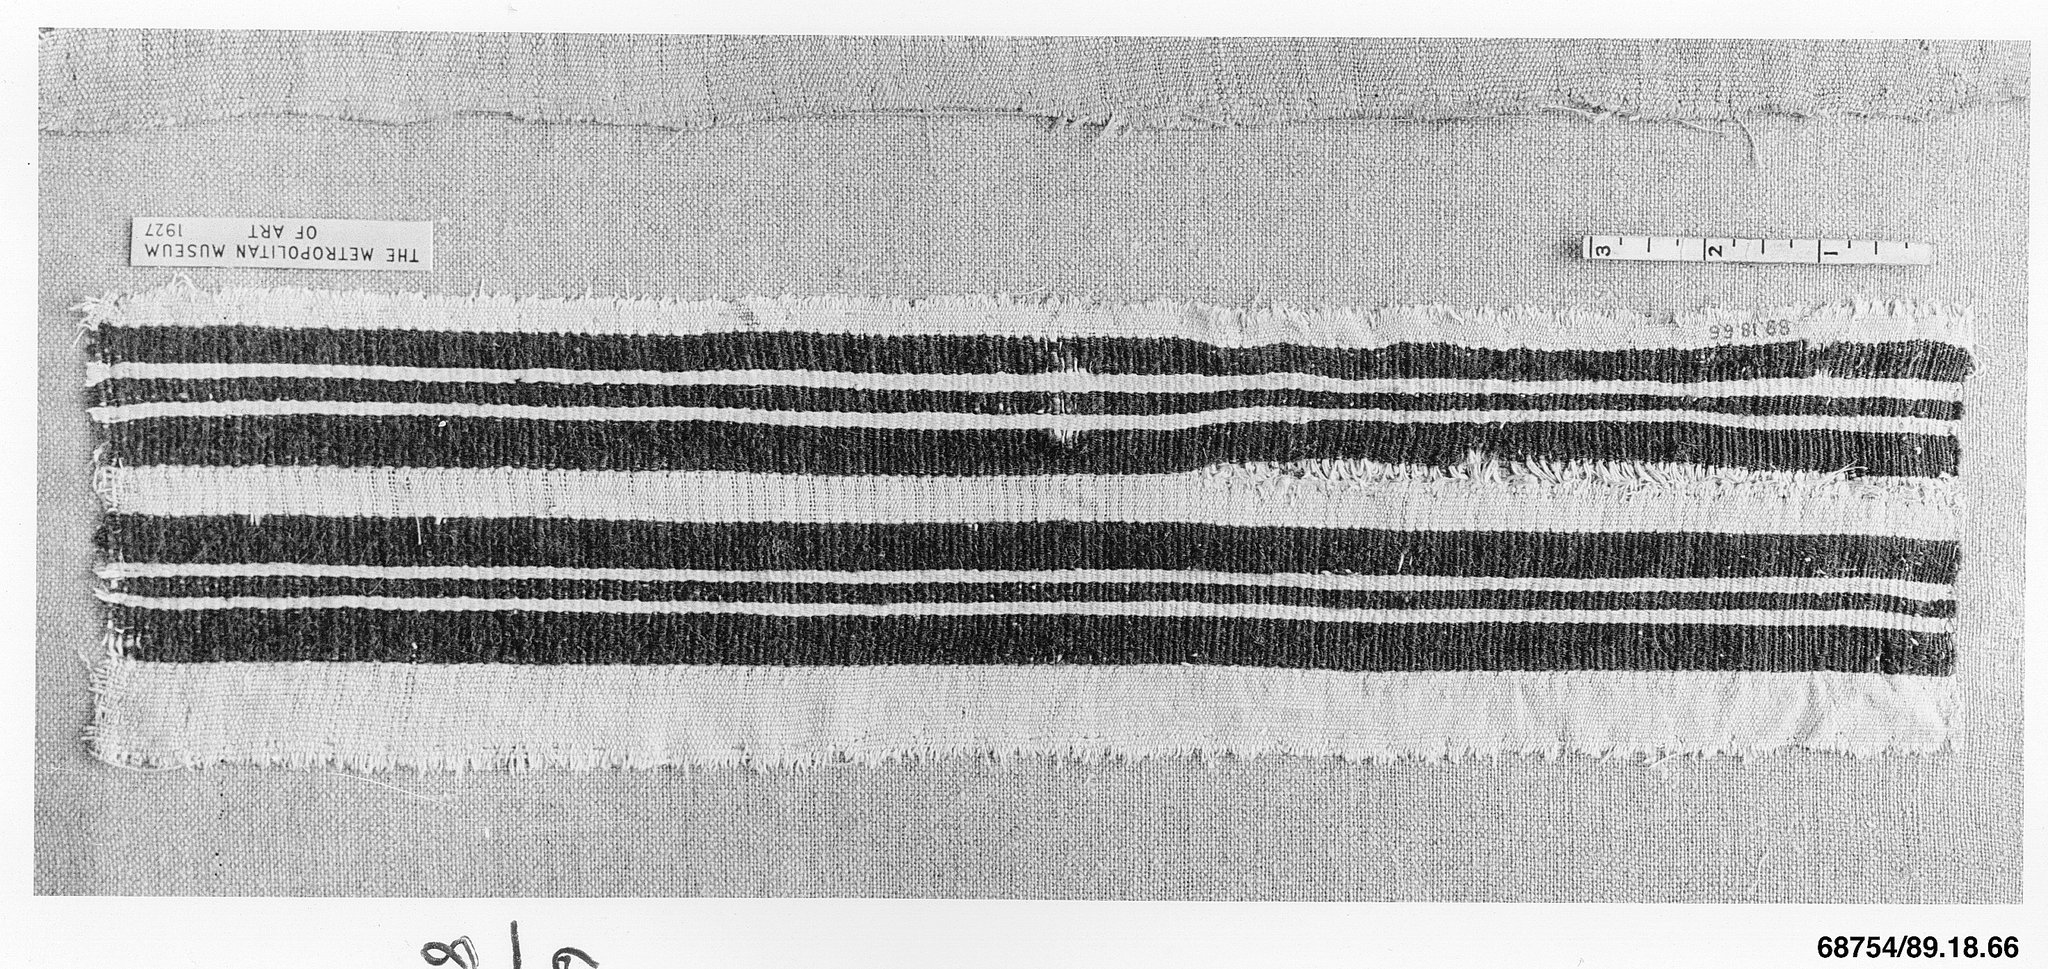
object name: textile fragment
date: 201-400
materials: linen, wool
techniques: weave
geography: egypt